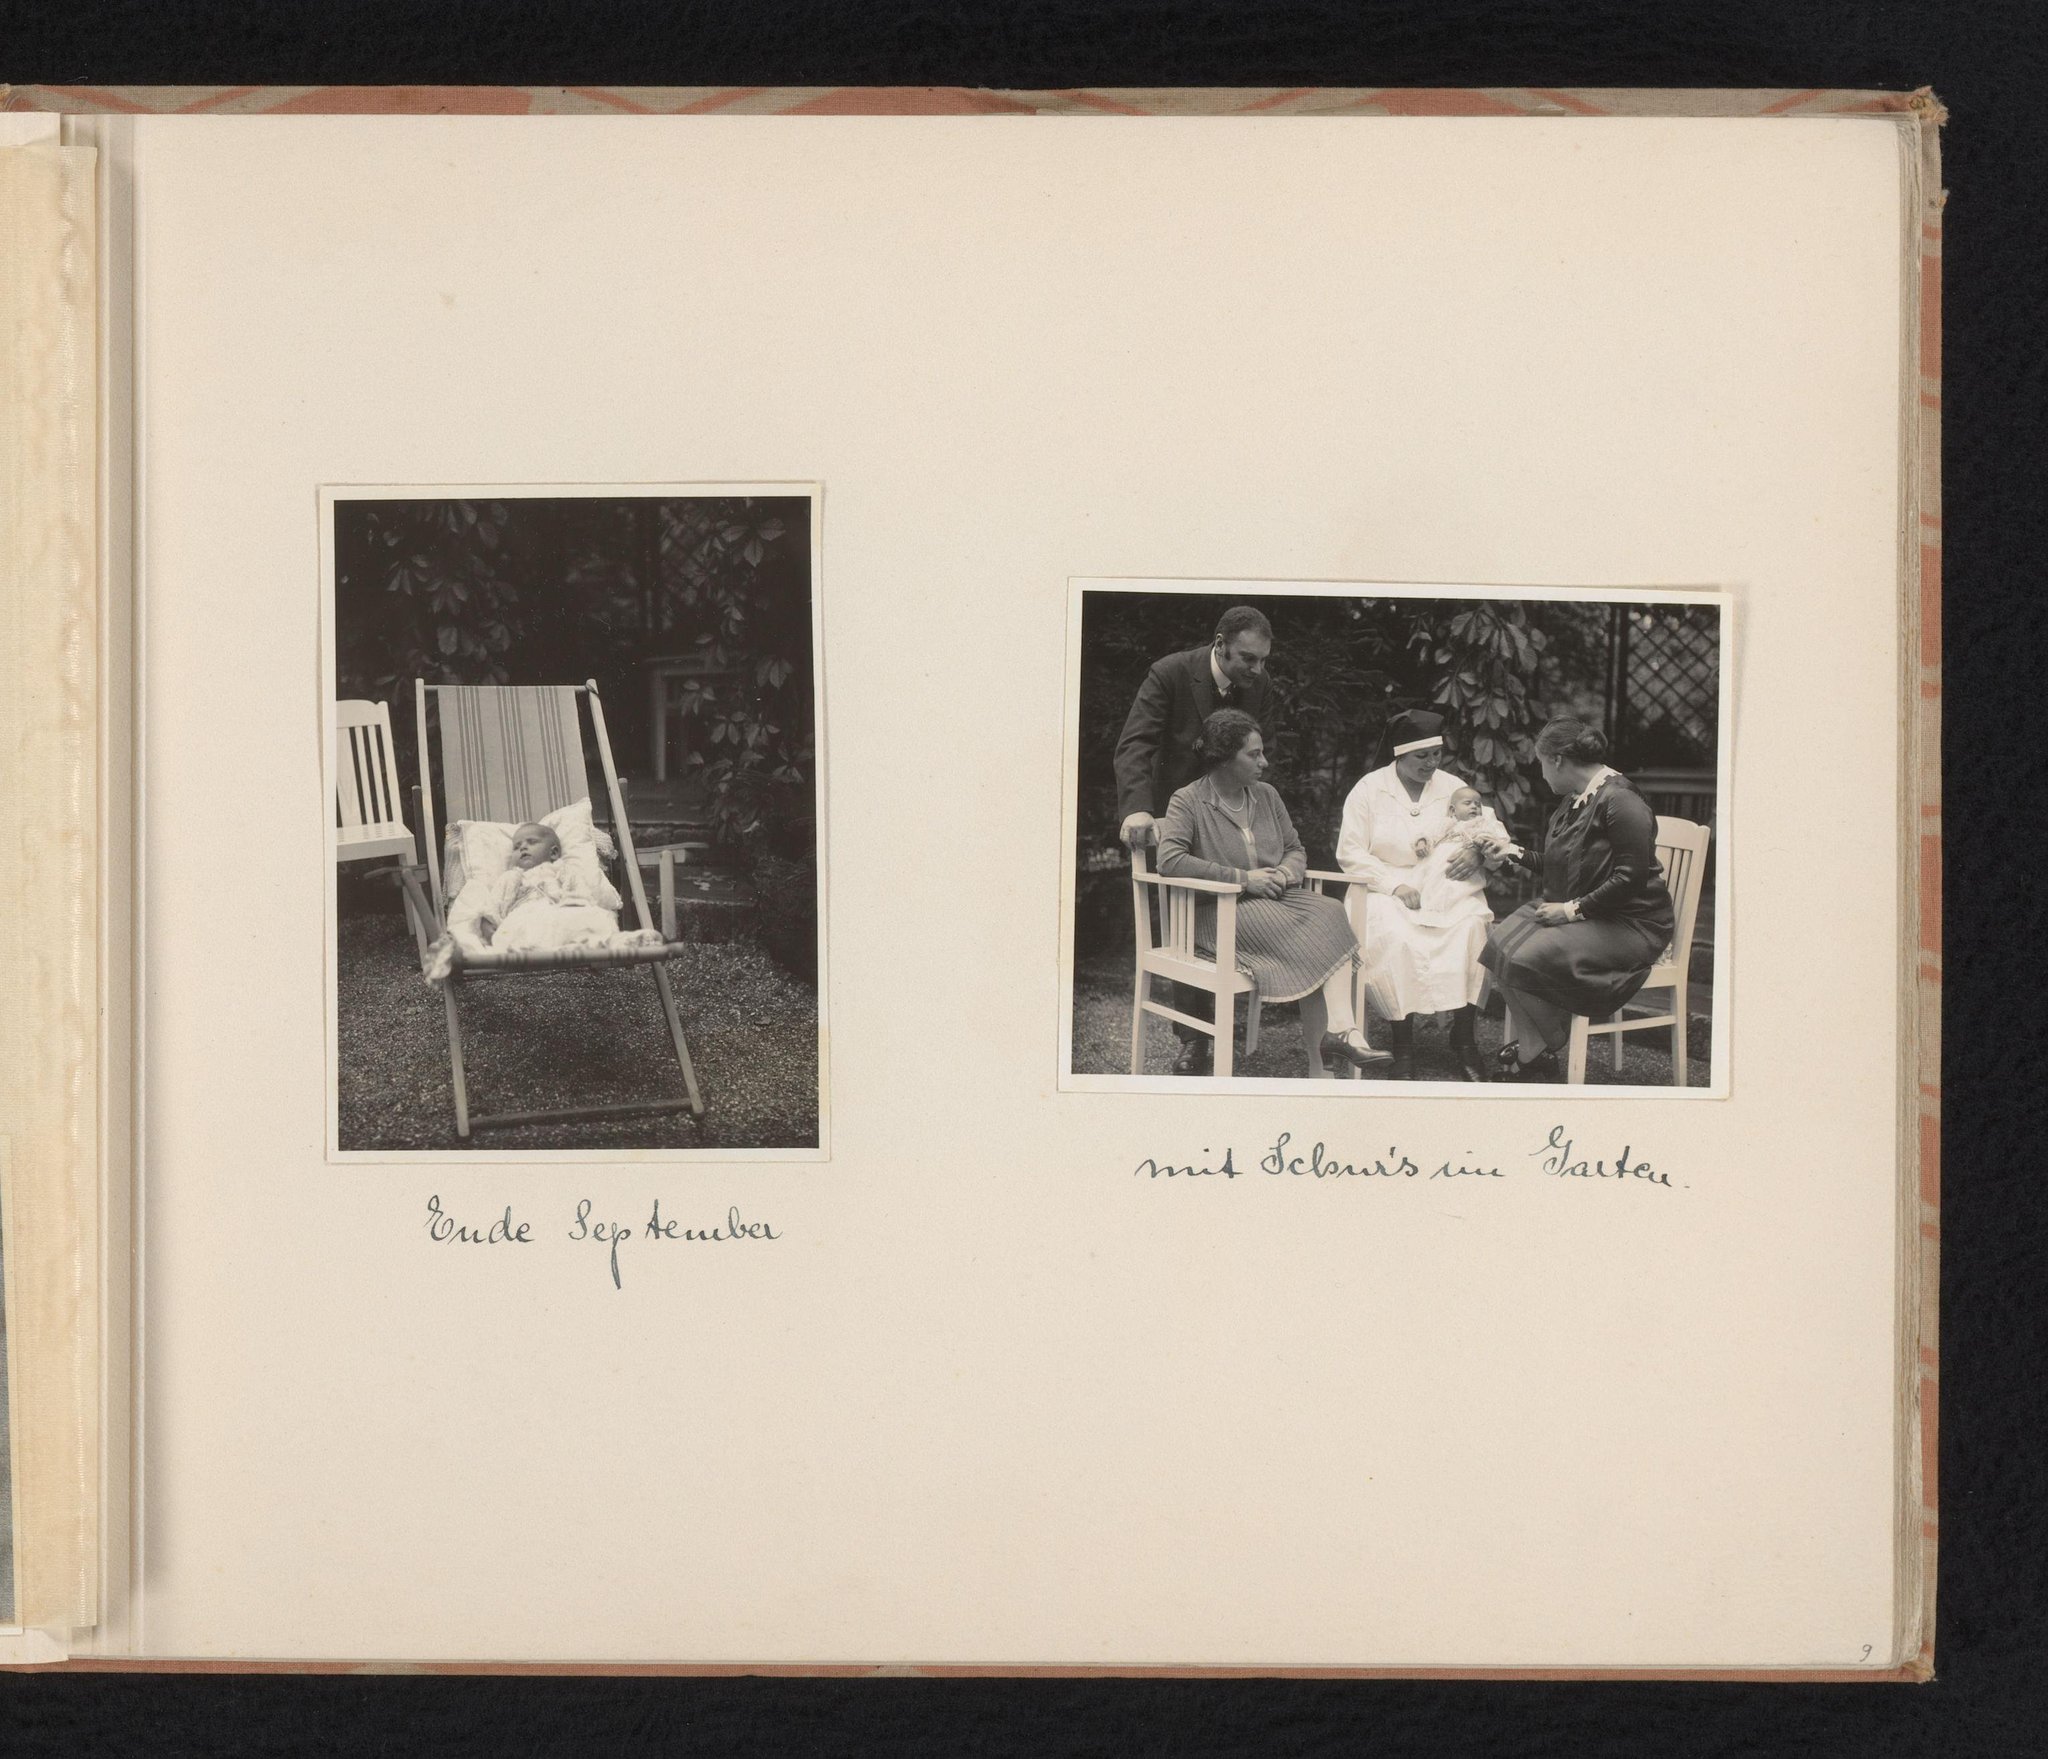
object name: photograph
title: Isabel Wachenheimer drie maanden oud met haar moeder Else Wachenheimer-Moos, een onbekende verpleegster en twee onbekende mensen, september 1928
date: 1909-1928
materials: paper, photographic support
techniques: gelatin silver print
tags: else wachenheimer-moos, leiden, isabel wachenheimer-elon, family life at home, mother and baby or young child, infant, baby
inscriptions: inscription: ‘Ende September//mit Schur's in Garten’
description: Albumblad met twee foto's. Foto links, Isabel Wachenheimer; foto rechts, onbekende man (links), onbekende vrouw (2e van links), onbekende verpleegster (midden), Isabel Wachenheimer (2e van rechts), Else Wachenheimer-Moos (1e van rechts). Onderdeel van het fotoalbum met foto's van Isabel Wachenheimer als kind (1928-1931).